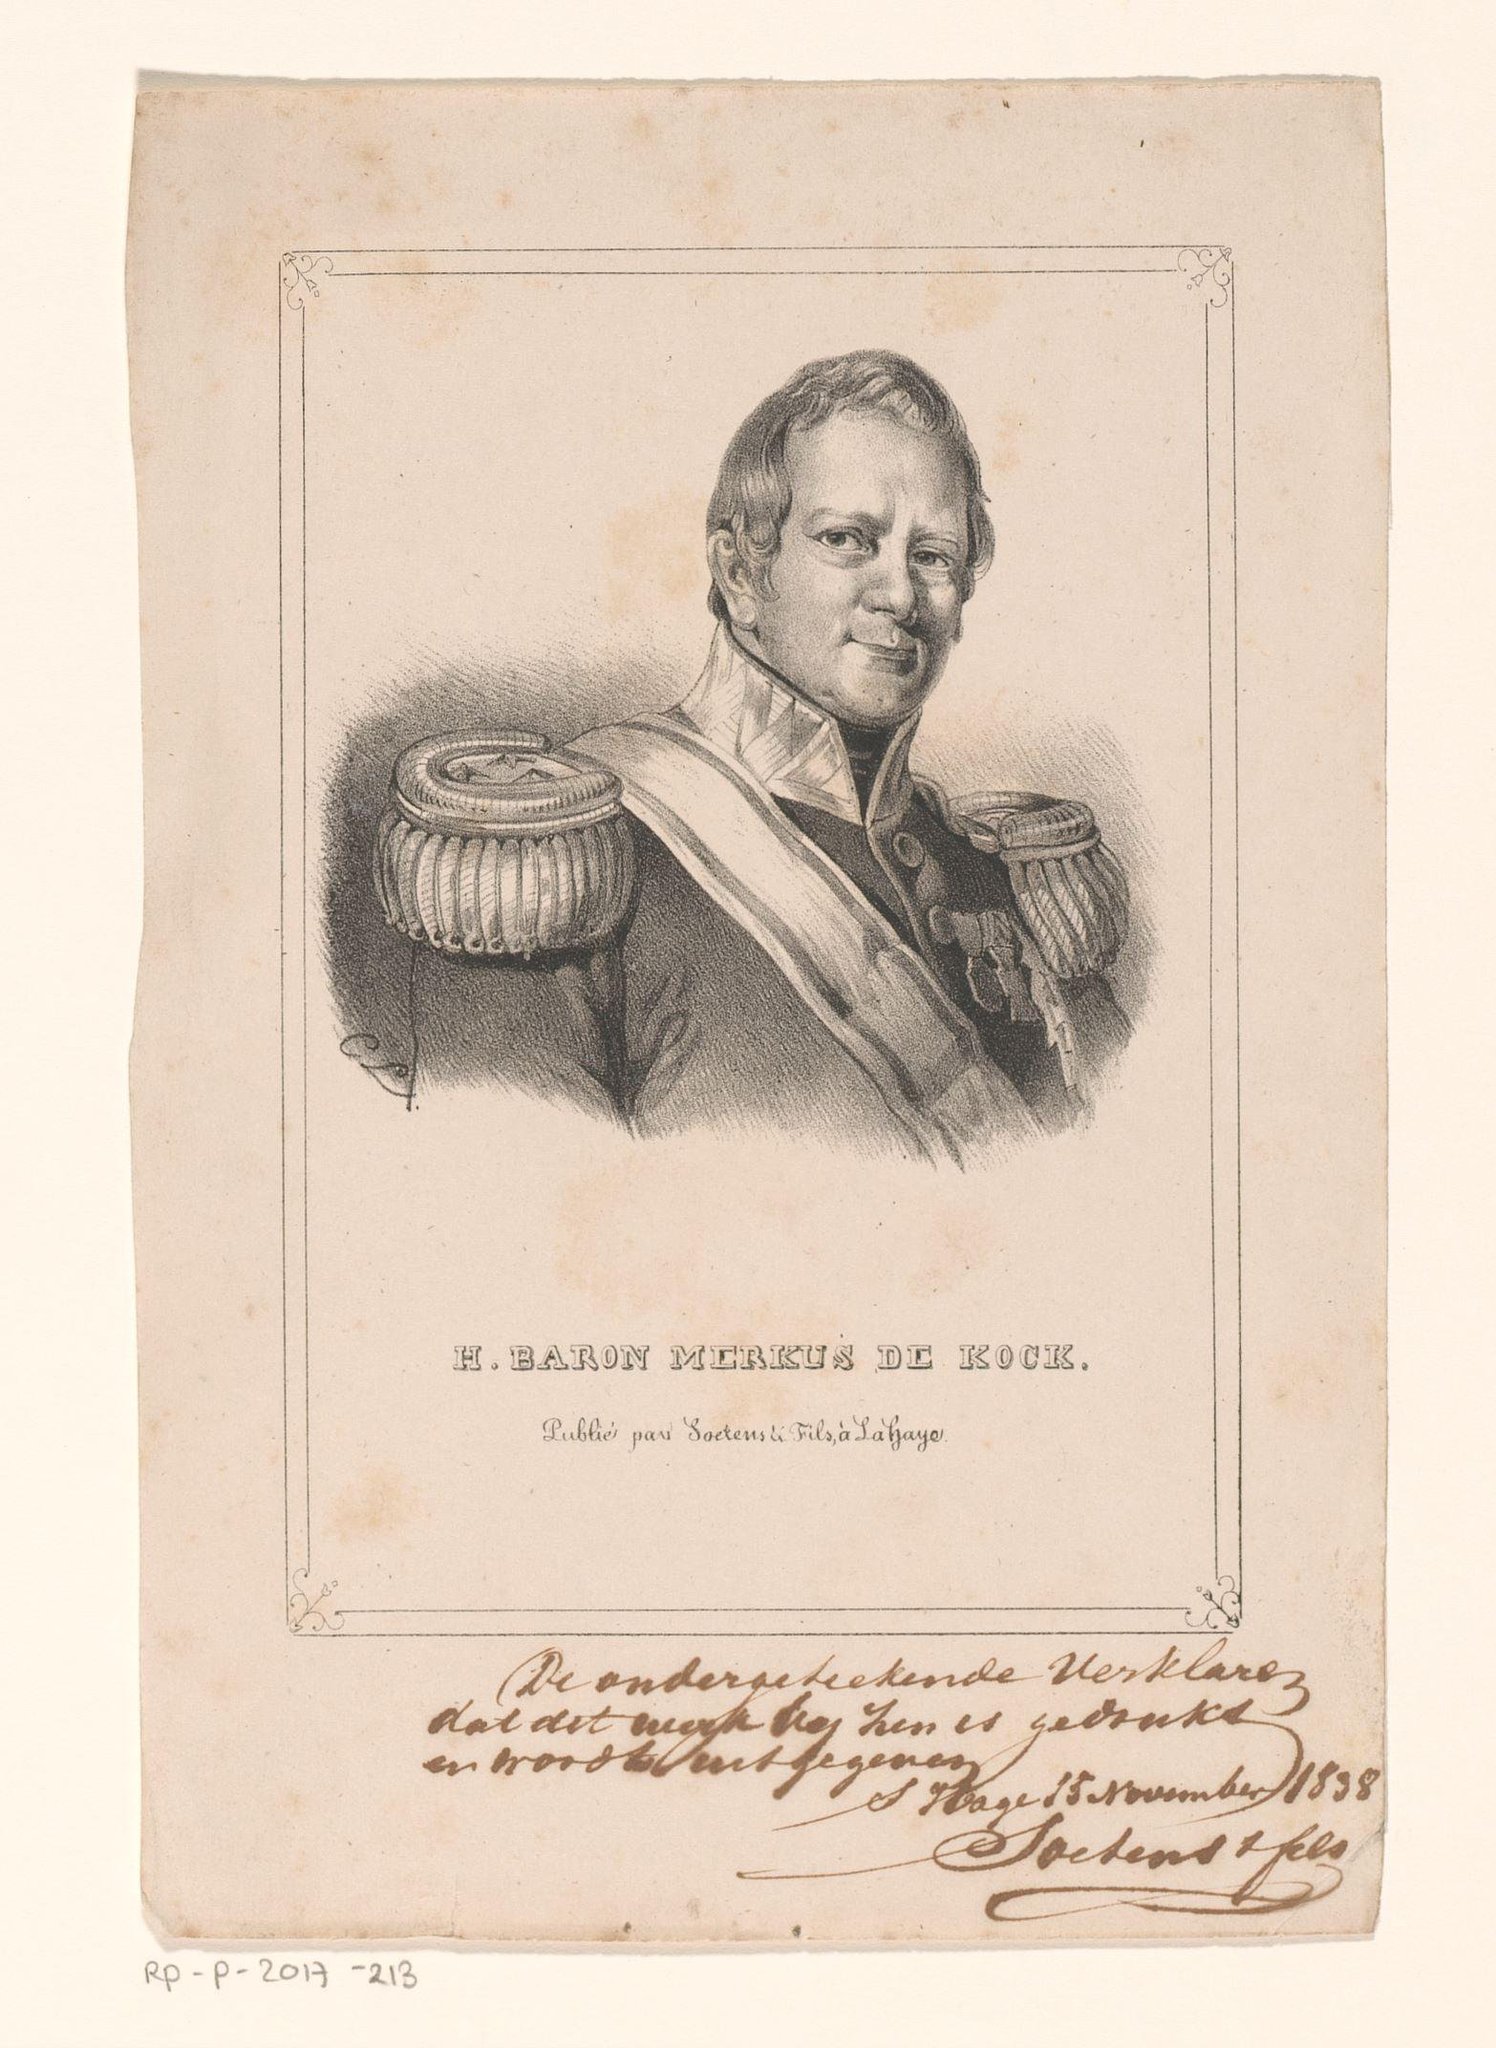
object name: print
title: Portret van Hendrik Merkus de Kock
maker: carel christiaan antony last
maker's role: print maker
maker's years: 1808-1876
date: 1837-1840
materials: paper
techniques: lithograph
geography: amsterdam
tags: historical persons (+ (full) bust portrait)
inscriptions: : ‘De ondergeteekende verklaren dat dit werk / bij hen is gedrukt en wordt uitgegeven / s Hage 15 november 1838 / Soetens&Fils’